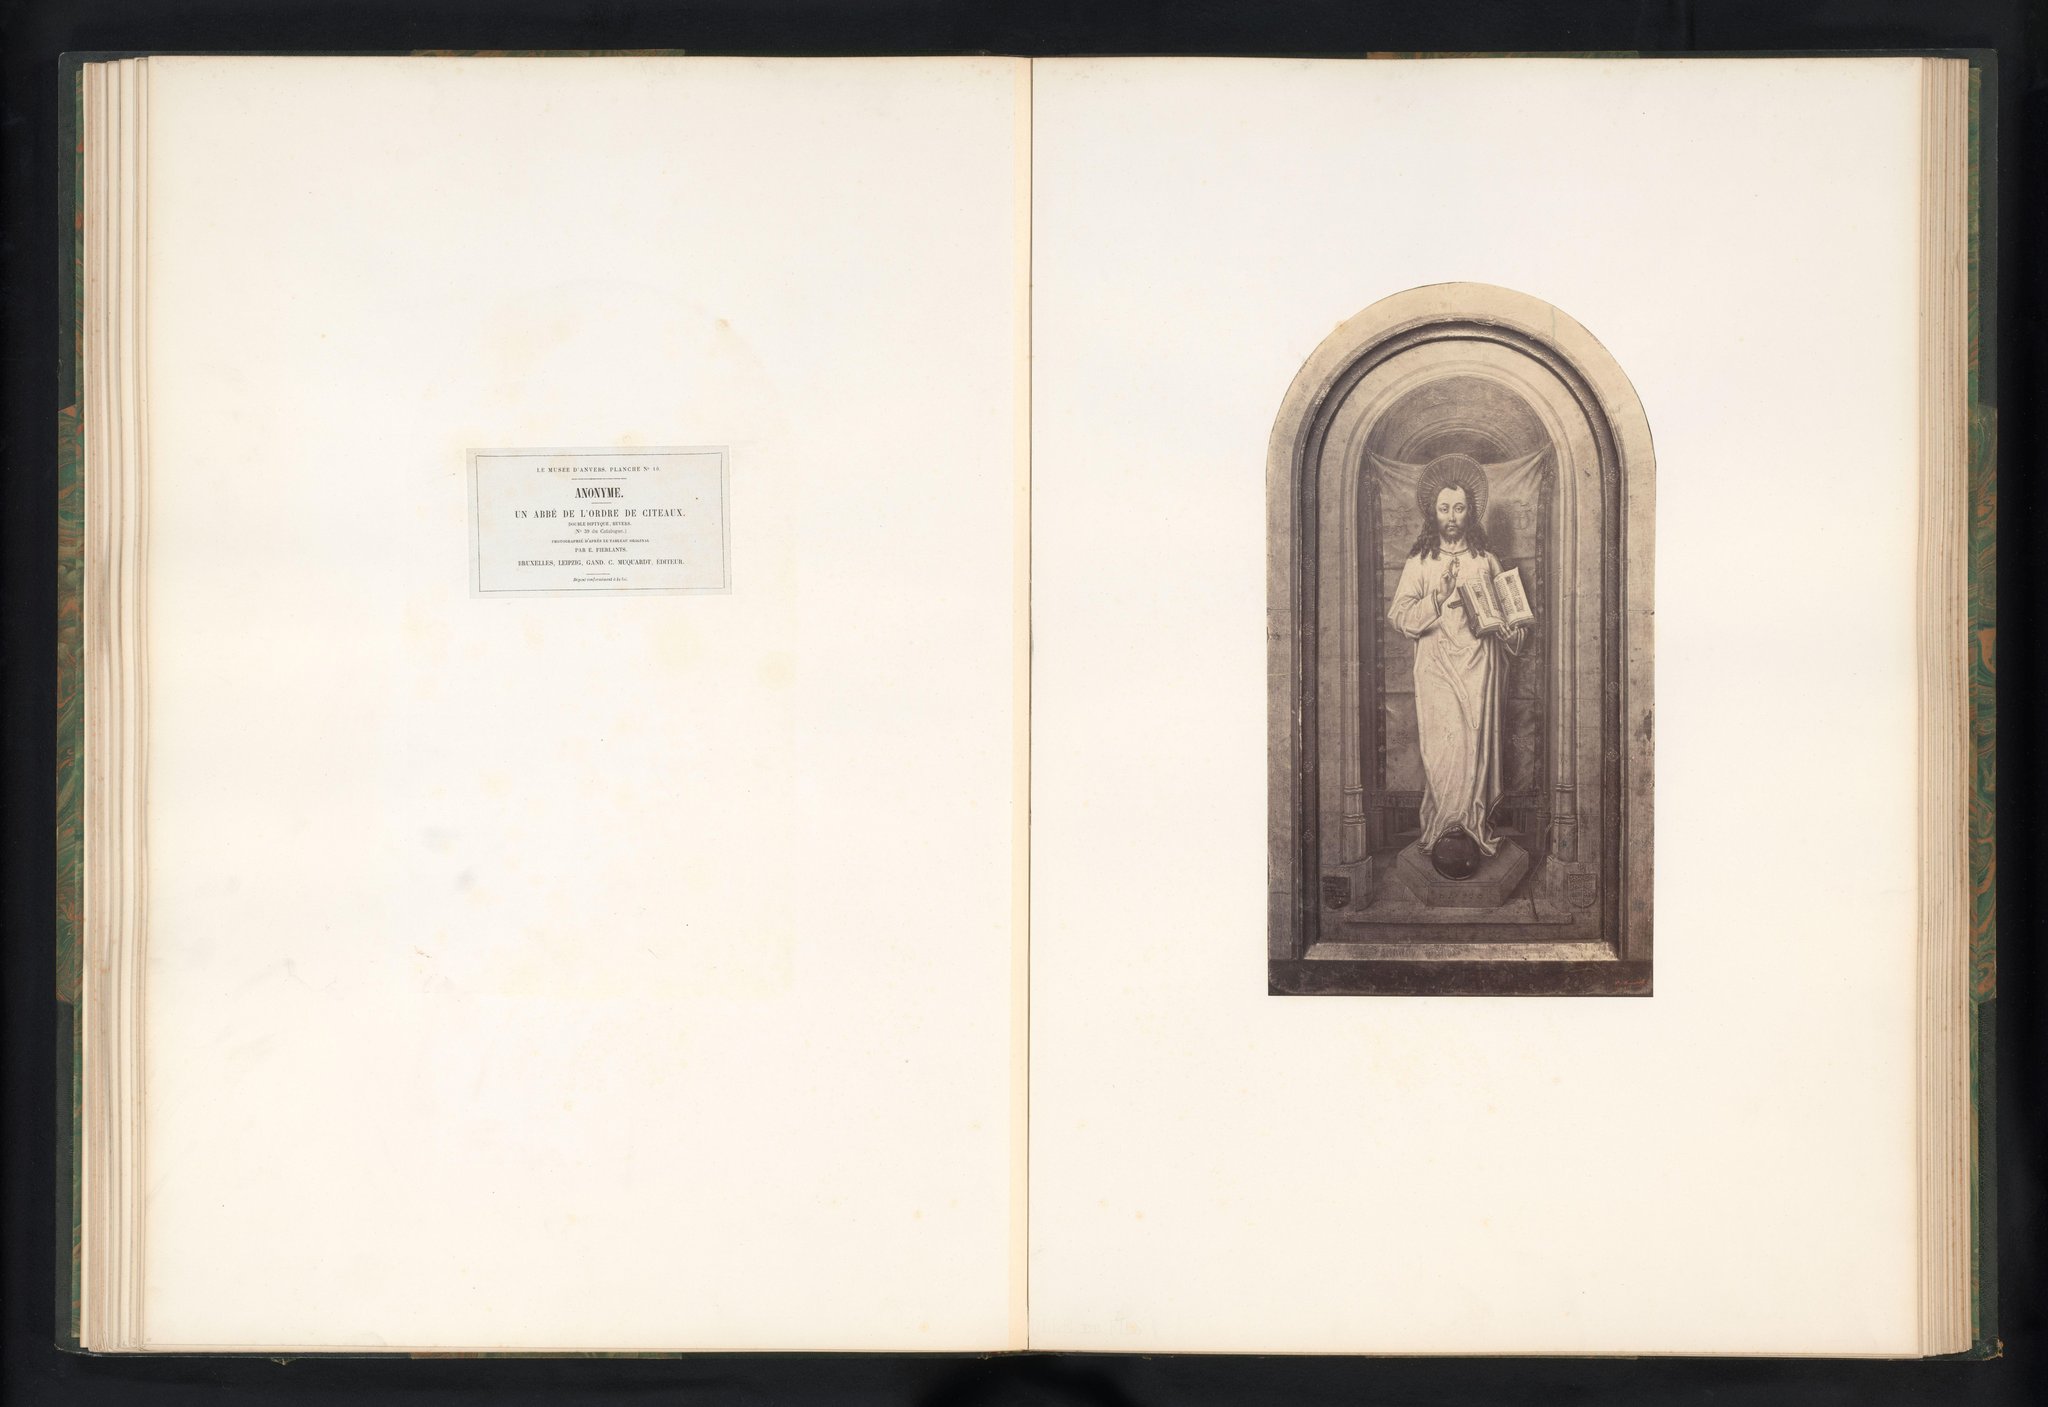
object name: photograph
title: Fotoreproductie van Christus als Salvator Mundi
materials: photographic support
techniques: albumen print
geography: brussels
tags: 'salvator mundi', making a blessing gesture; an orb in his hand or at his feet